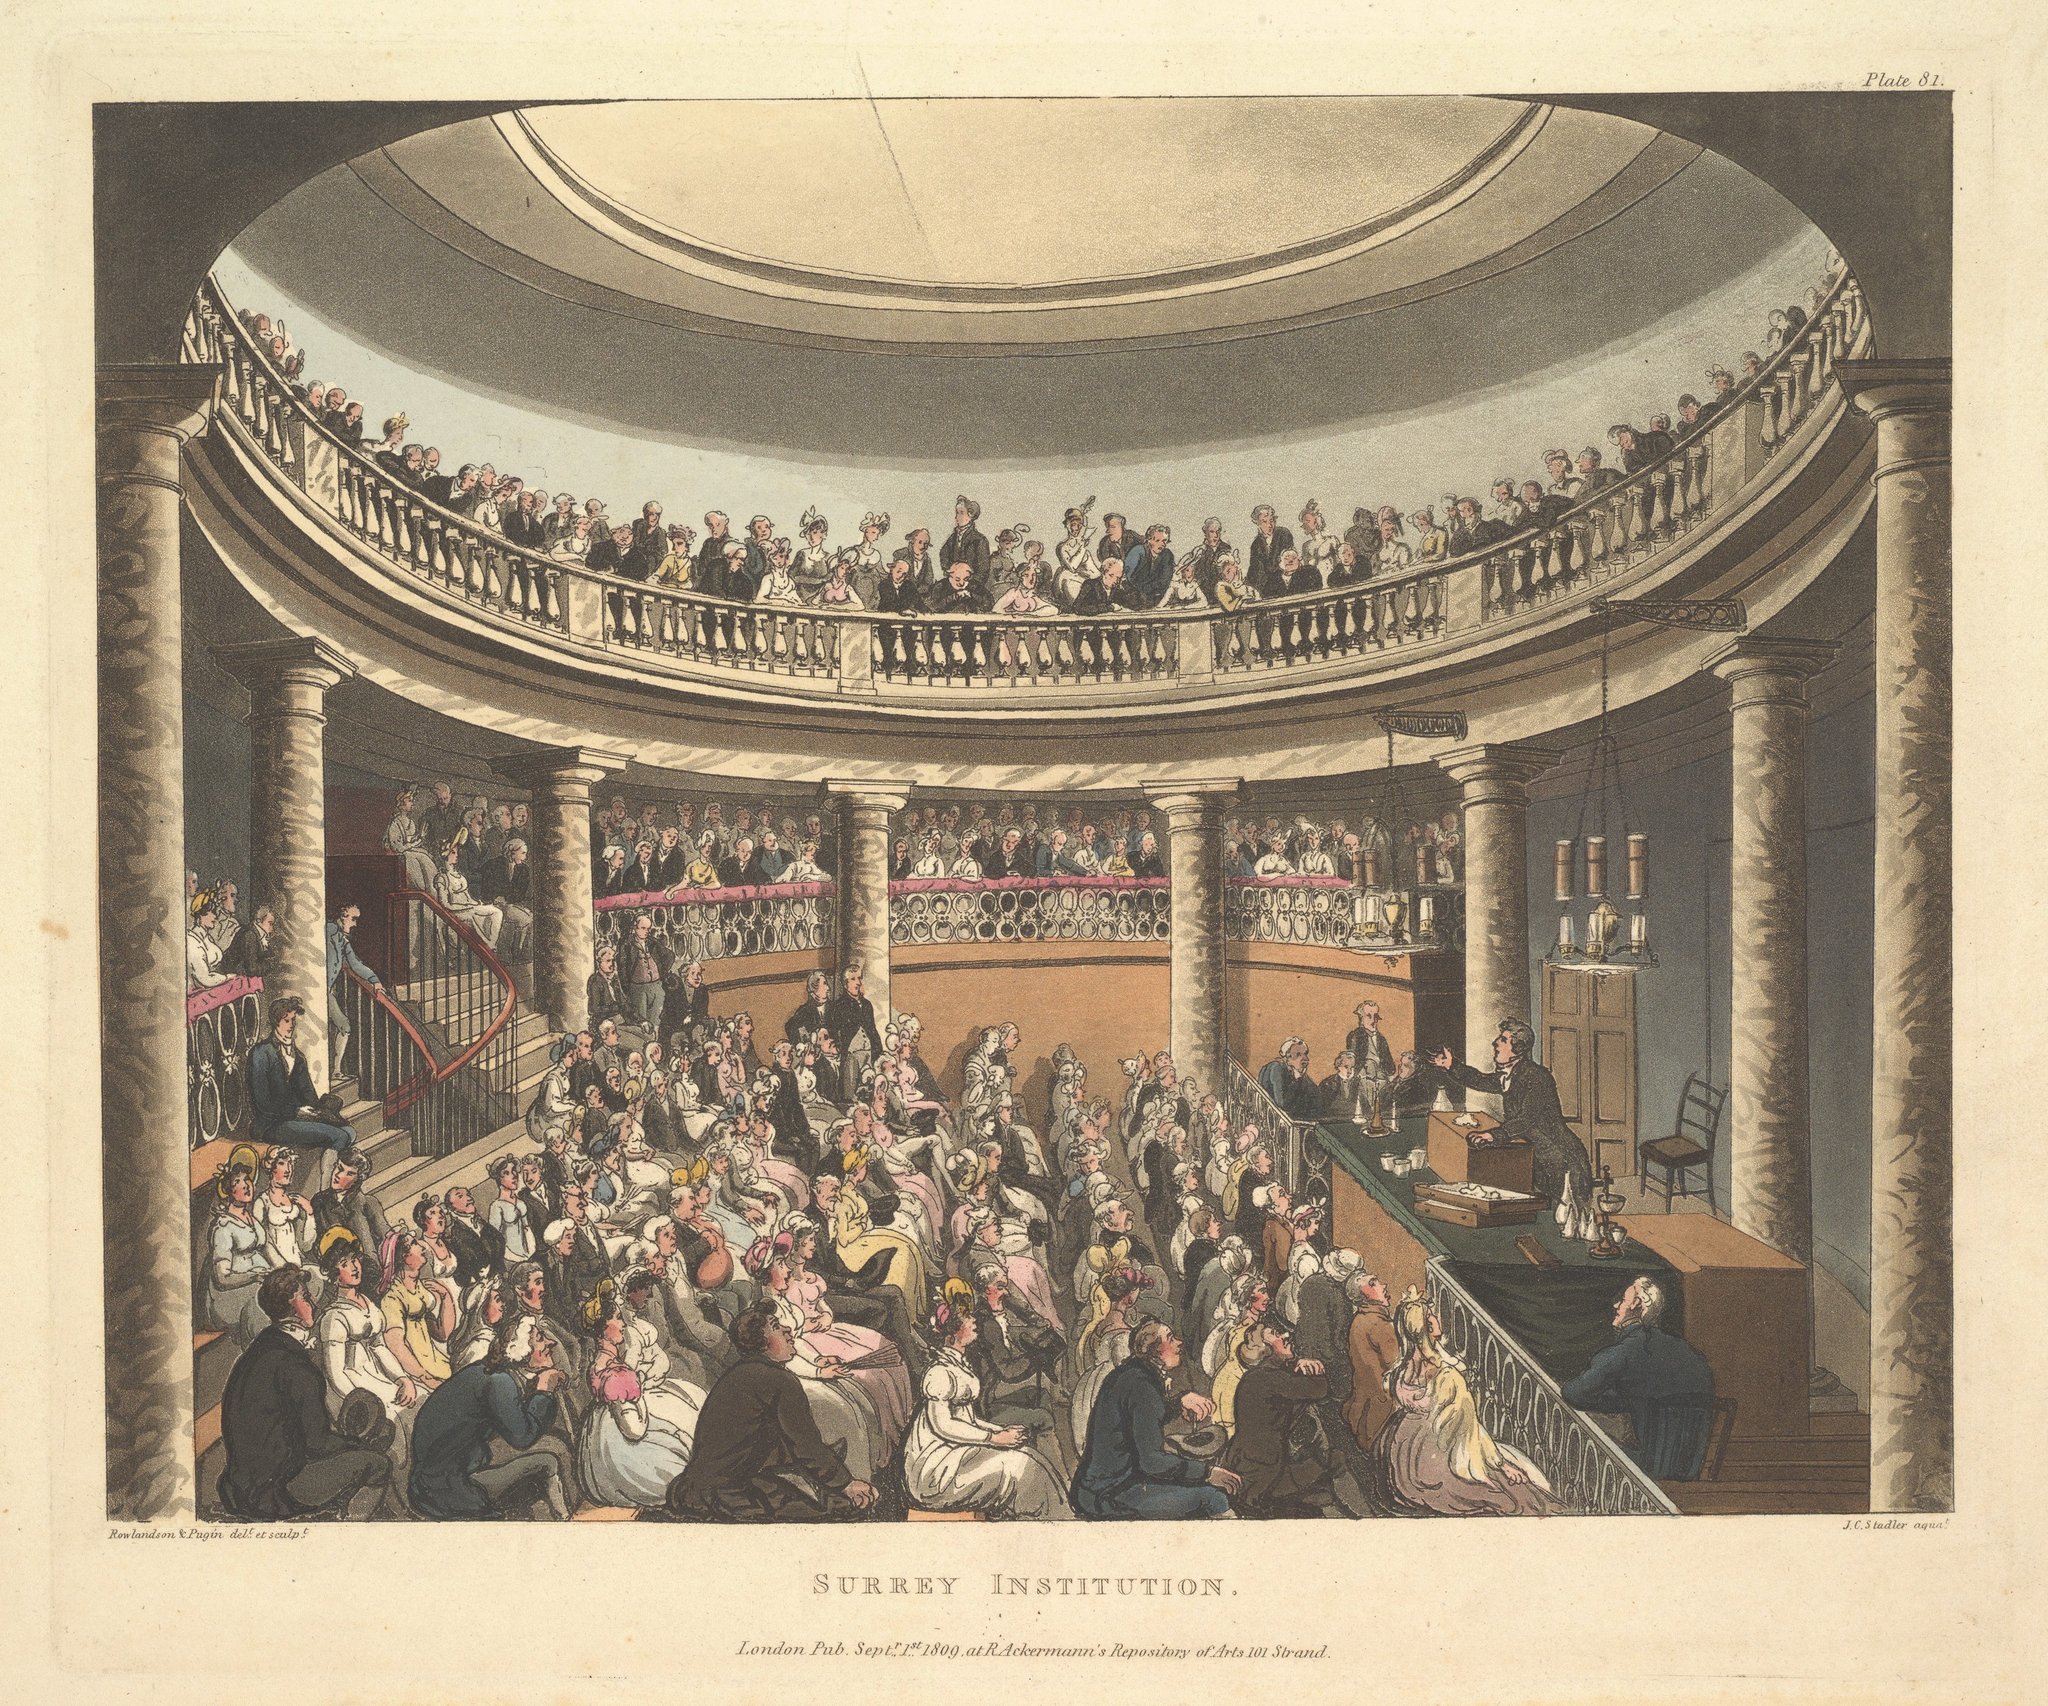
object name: print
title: Surrey Institution, plate 81 from "Microcosm of London"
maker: thomas rowlandson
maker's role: artist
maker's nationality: british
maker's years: 1757-1827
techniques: aquatint, etching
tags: crowd